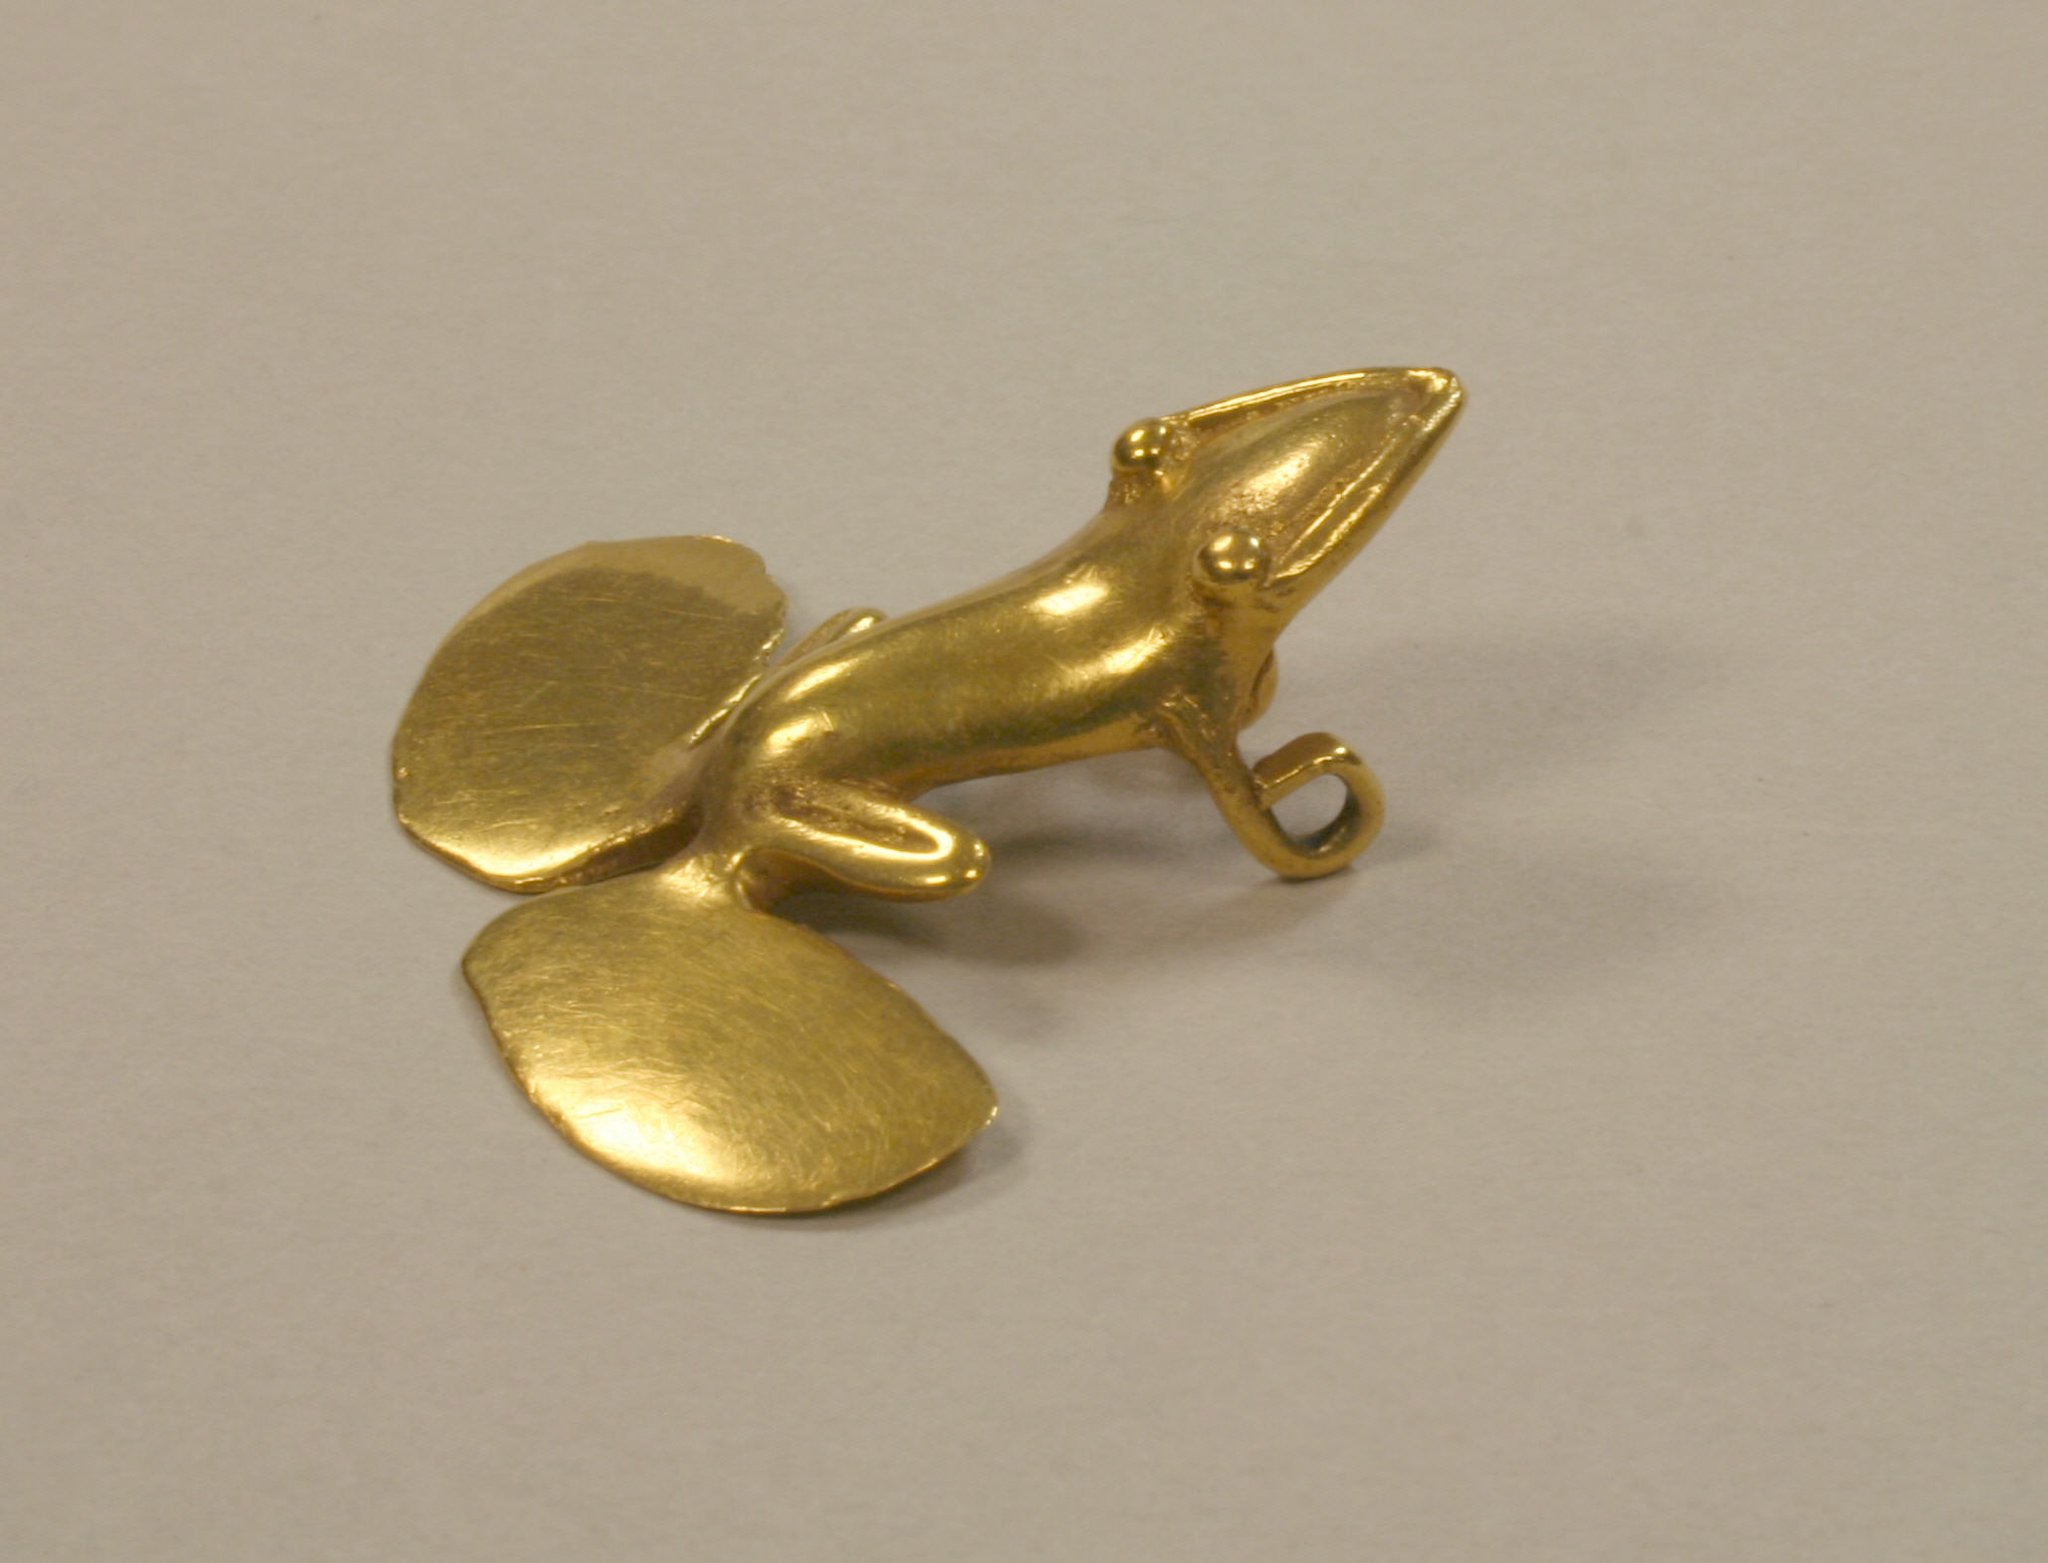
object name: pendant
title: Frog Pendant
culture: veraguas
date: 1001-1600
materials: gold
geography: panama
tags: frogs